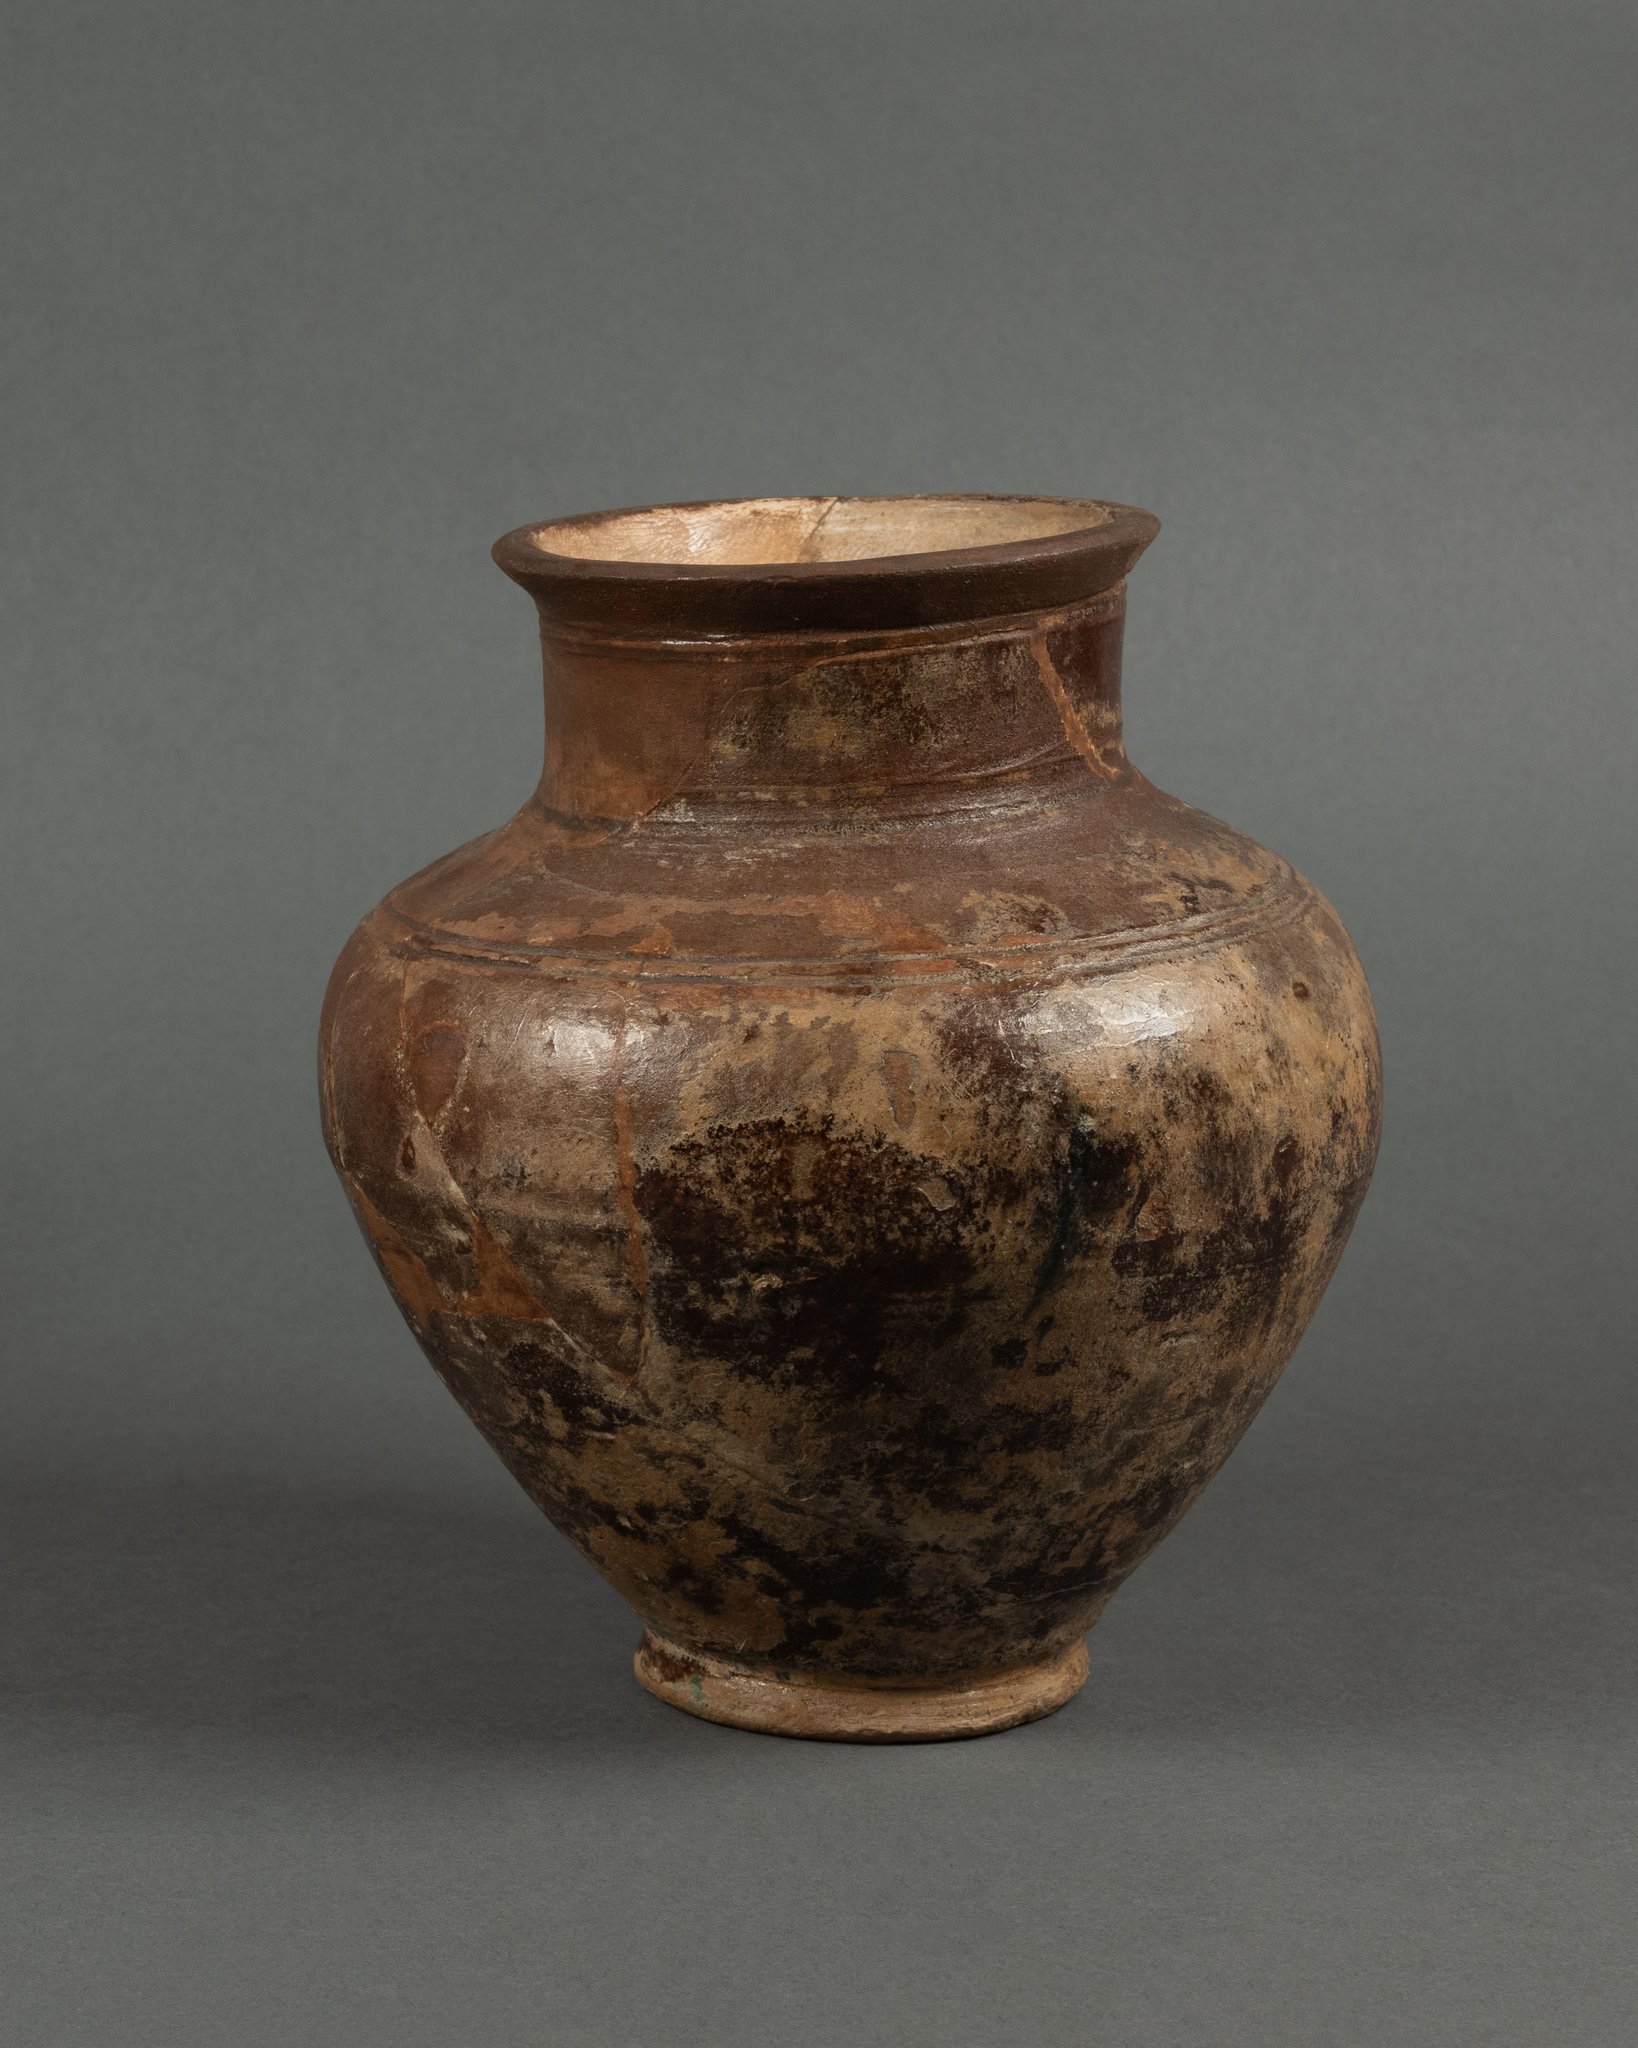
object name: jar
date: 801-1000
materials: earthenware, glaze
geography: iran